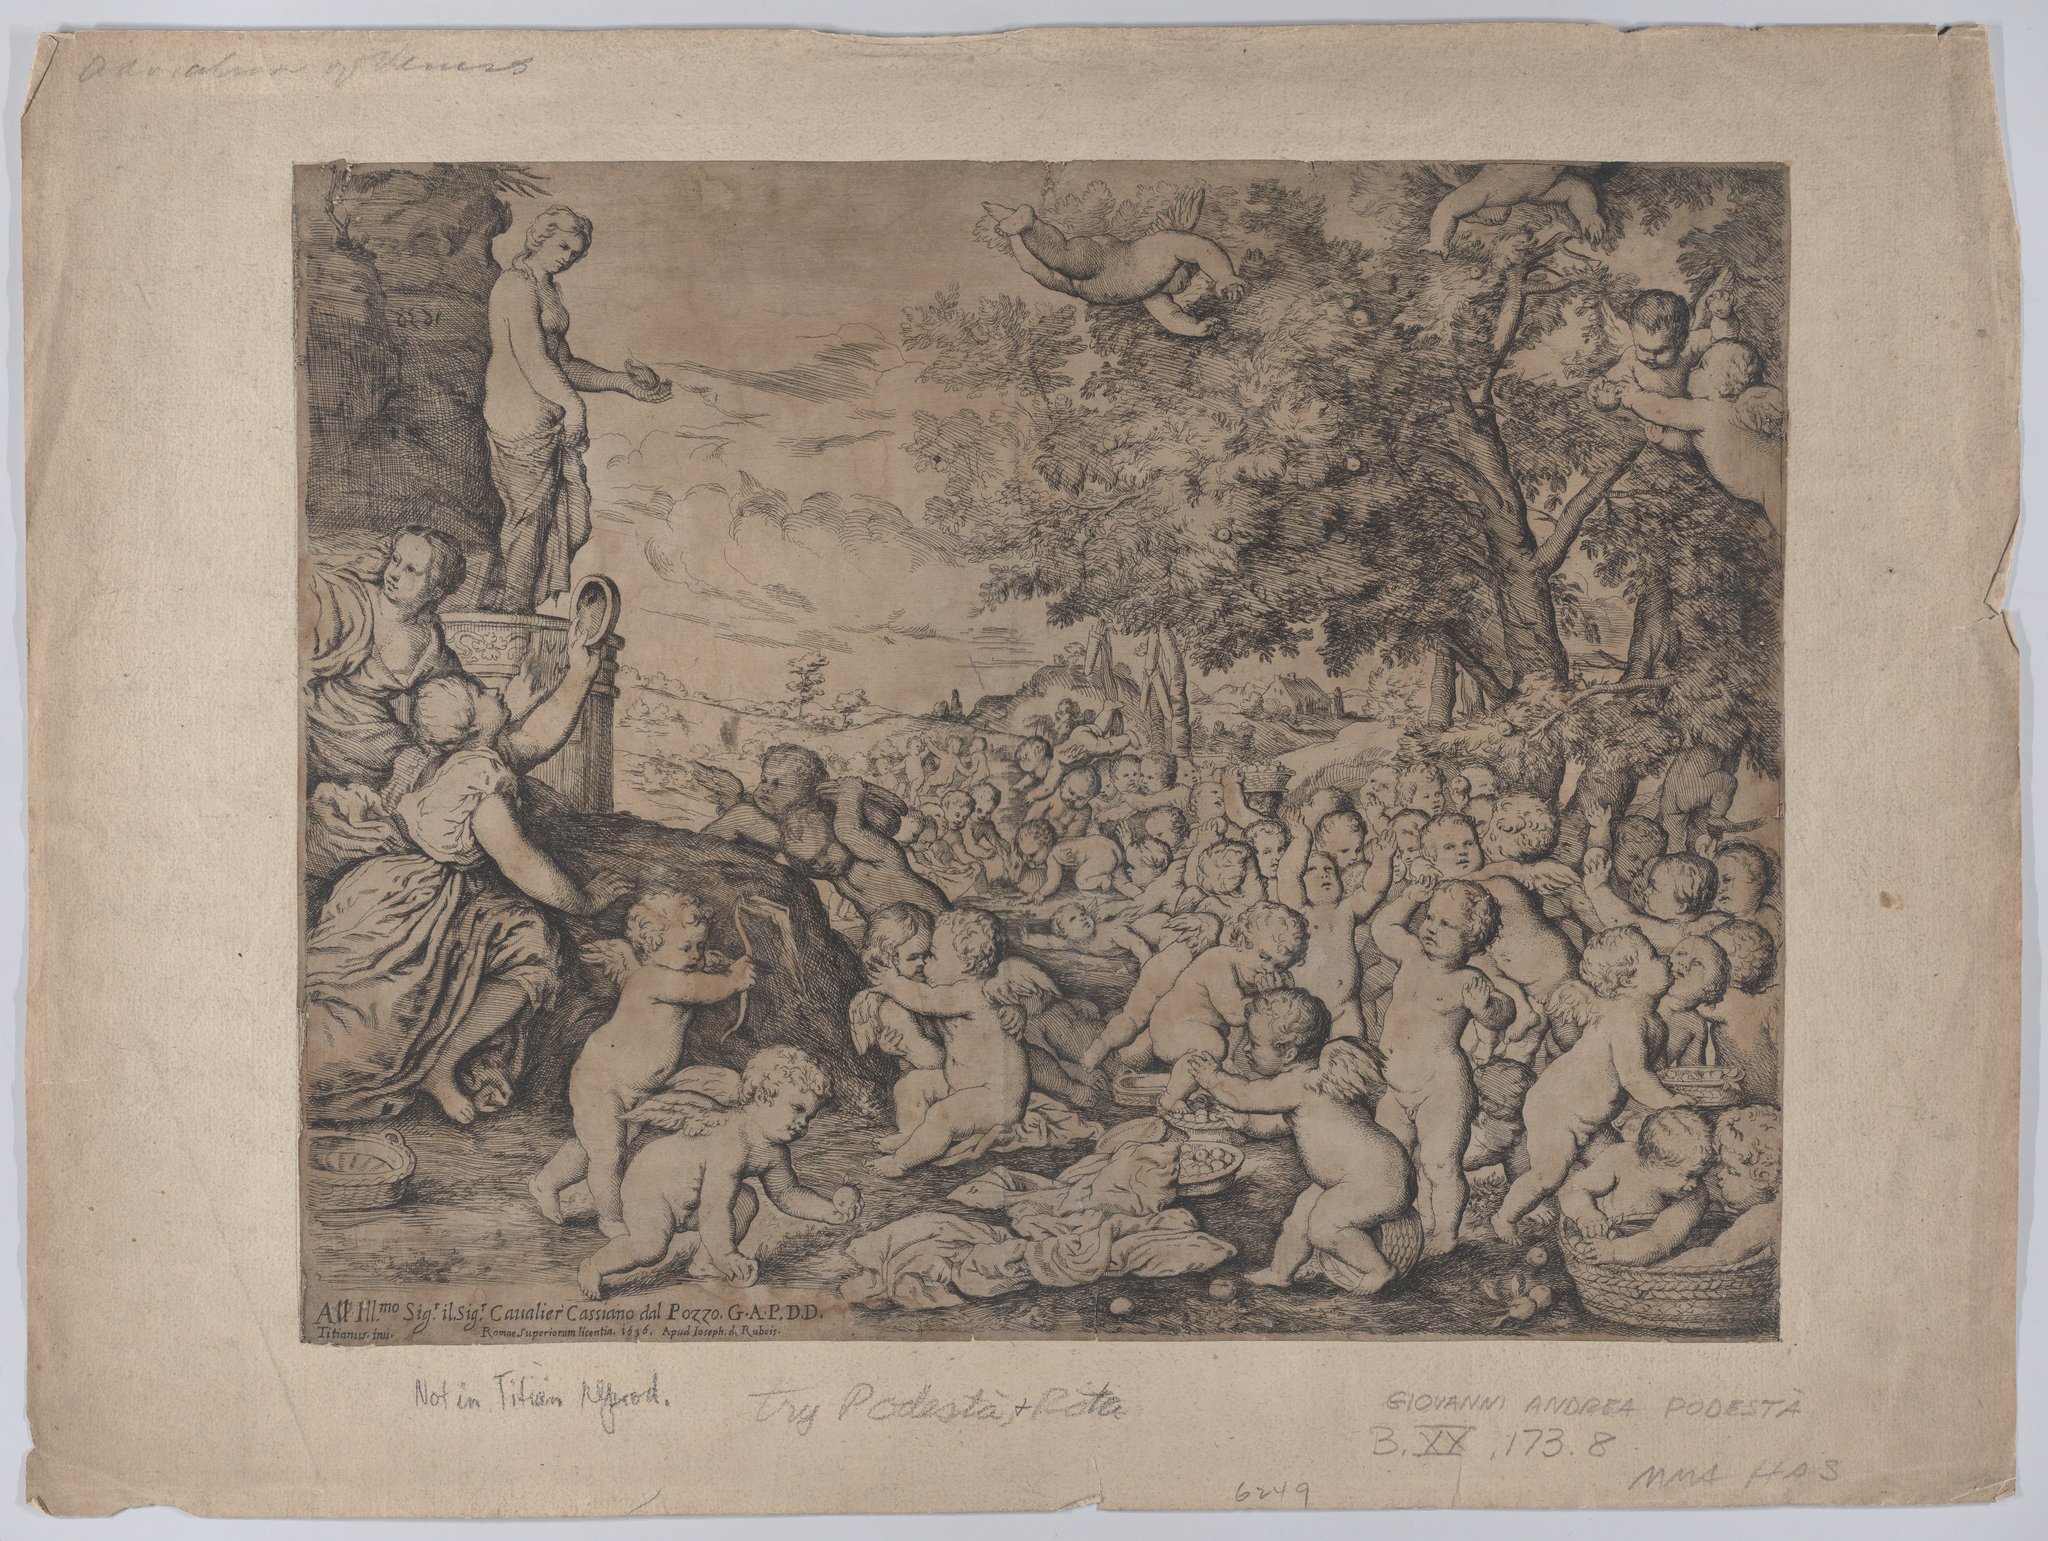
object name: print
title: Putti before a statue of Venus; after Titian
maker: giovanni andrea podestà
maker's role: artist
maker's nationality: italian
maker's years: 1608-1674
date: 1636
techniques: etching